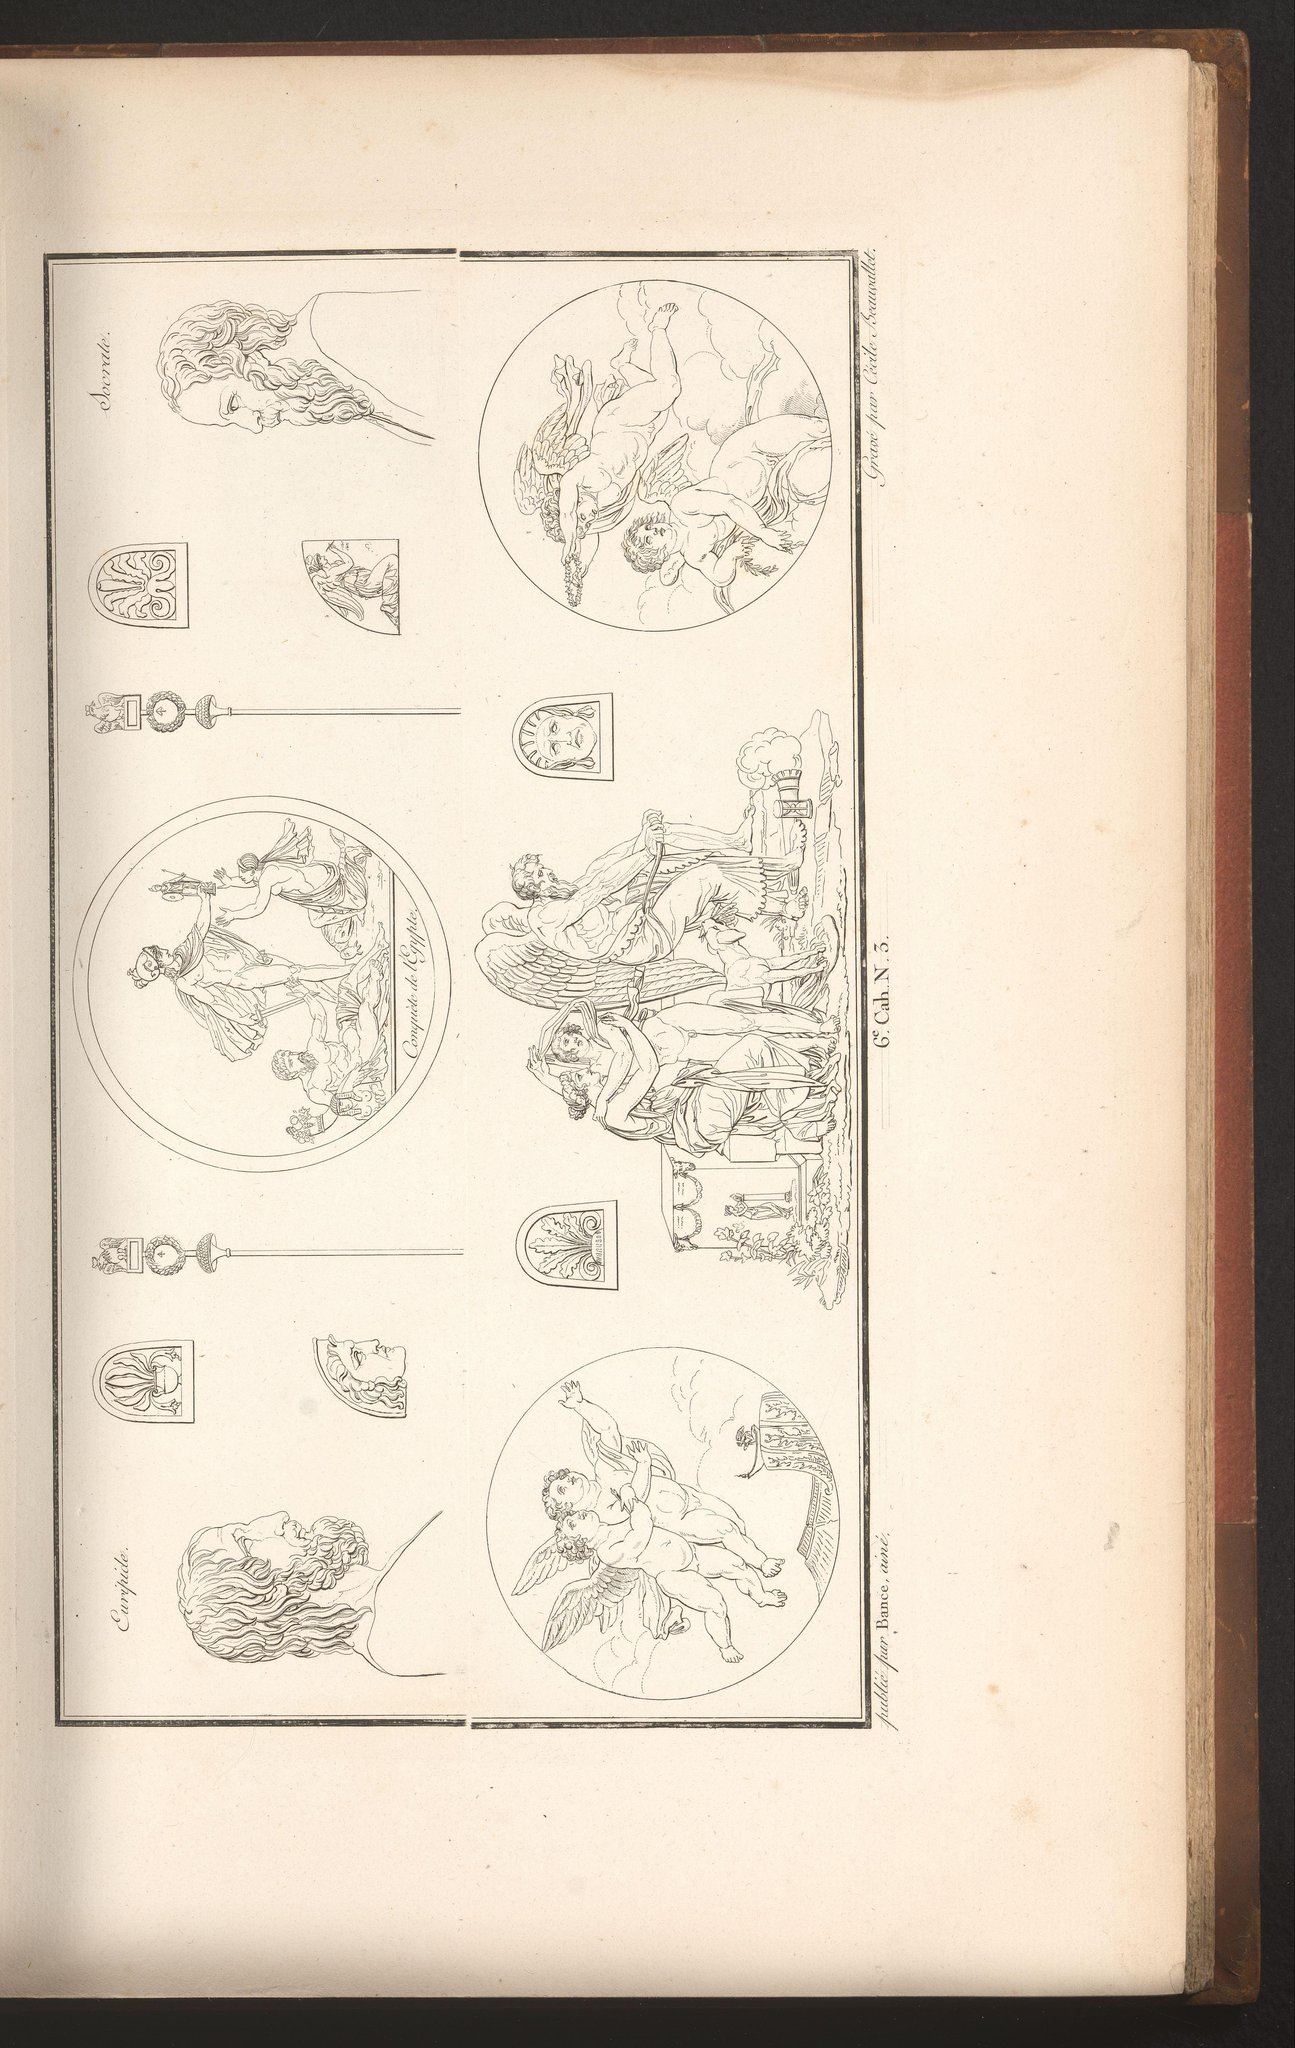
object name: ornament print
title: Mythologische en historische scènes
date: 1820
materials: paper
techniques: etching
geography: paris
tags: ornaments ~ art, daedalus makes the wings while icarus looks on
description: Ornamentprent met verschillende mythologische en historische scènes. Onderdeel (6e. Cah. N. 5) van het prentalbum met twee series van in totaal 138 ornamentprenten door Beauvallet en Normand, 'Fragmens d'Ornemens dans le Style Antique'.